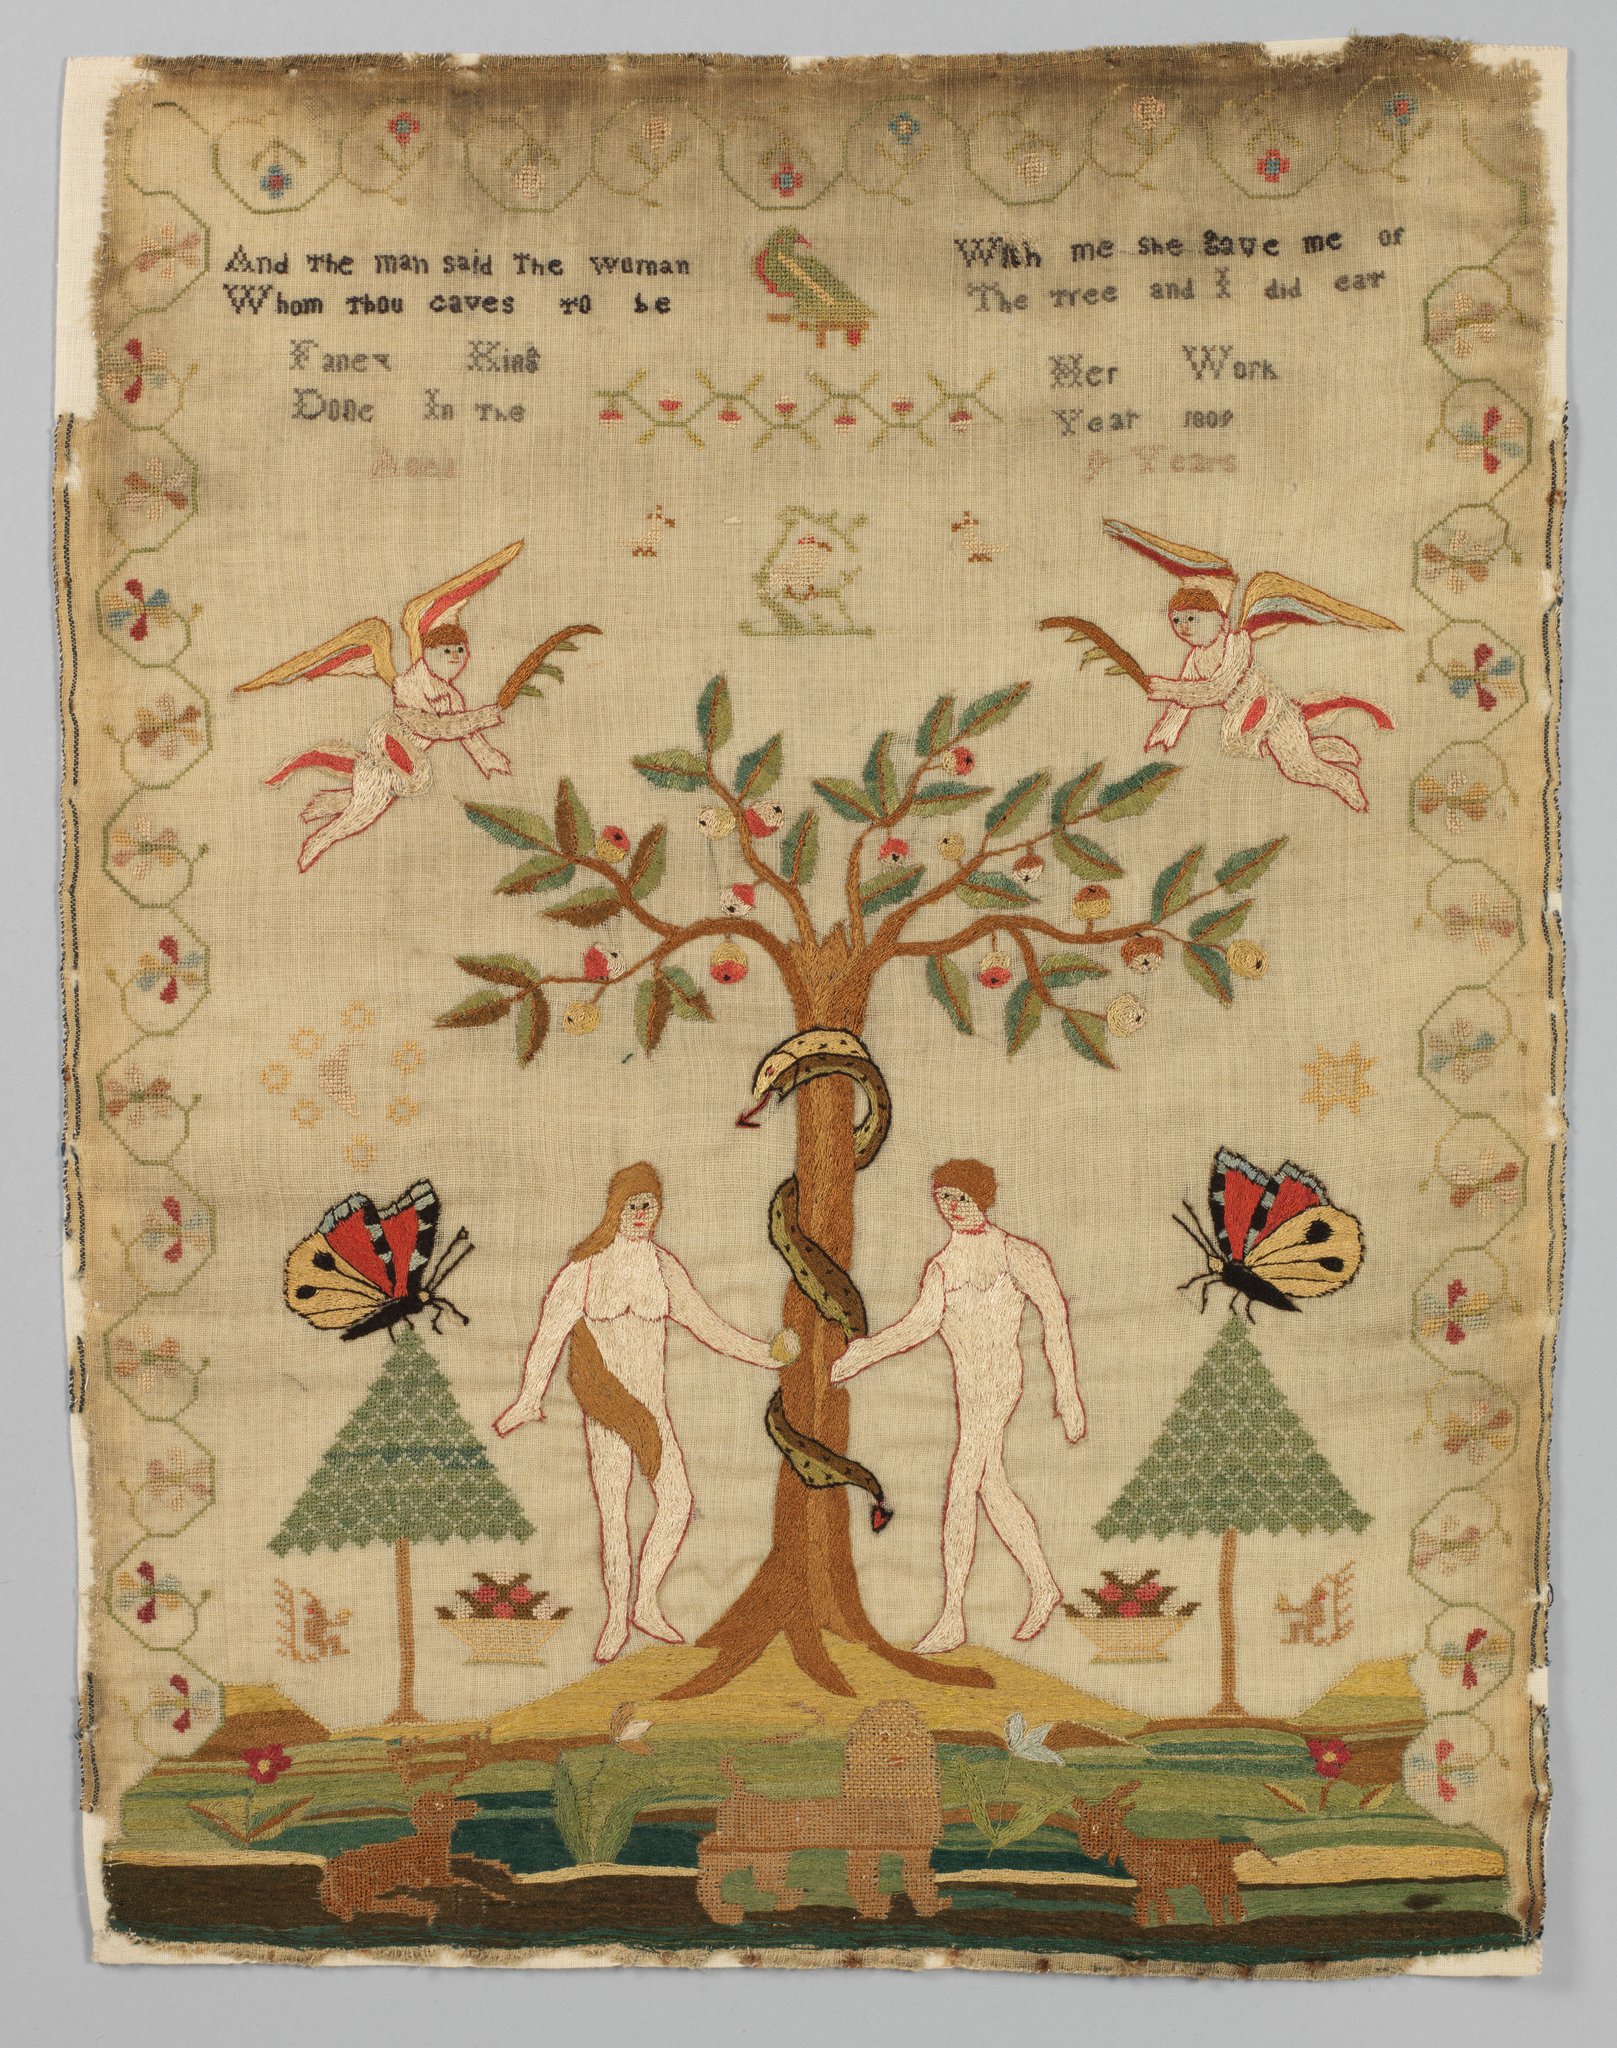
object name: sampler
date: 1809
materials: canvas, silk, wool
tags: dogs,goats,butterflies,lions,snakes,trees,angels,adam,eve